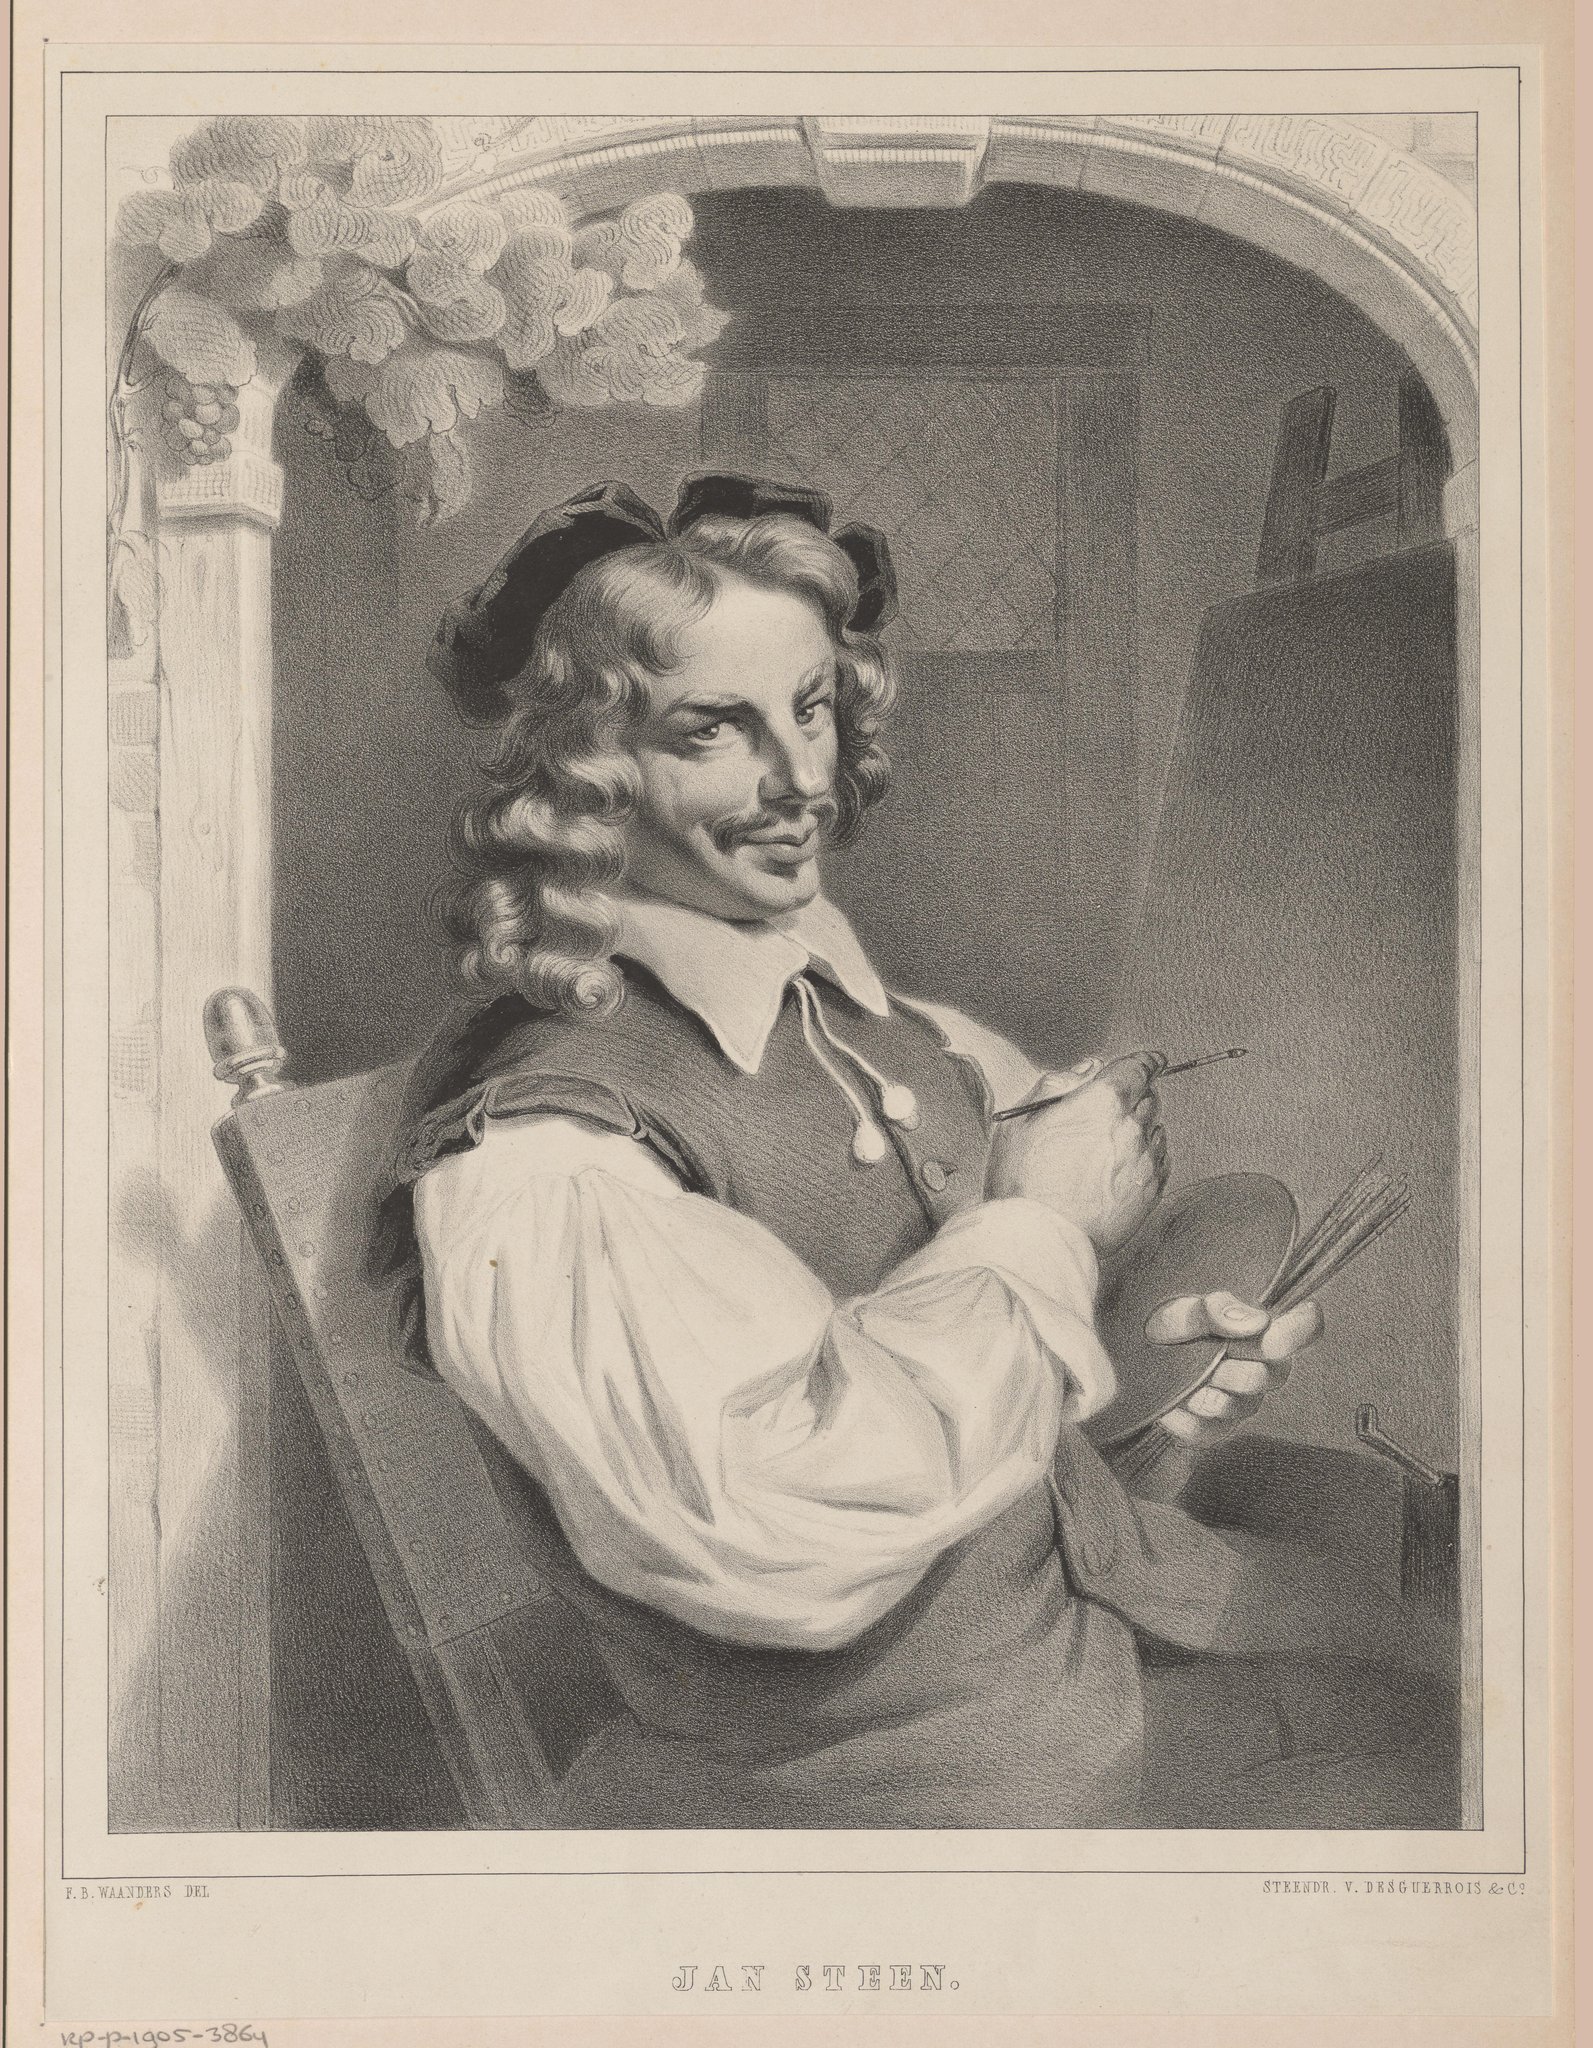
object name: print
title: Portret van Jan Havicksz. Steen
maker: franciscus bernardus waanders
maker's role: print maker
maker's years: 1809-1880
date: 1827-1880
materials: paper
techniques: lithograph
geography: amsterdam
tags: leiden, painter, print maker, jan havicksz. steen, historical persons, portrait, self-portrait of artist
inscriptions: collector's mark: Lugt 2228